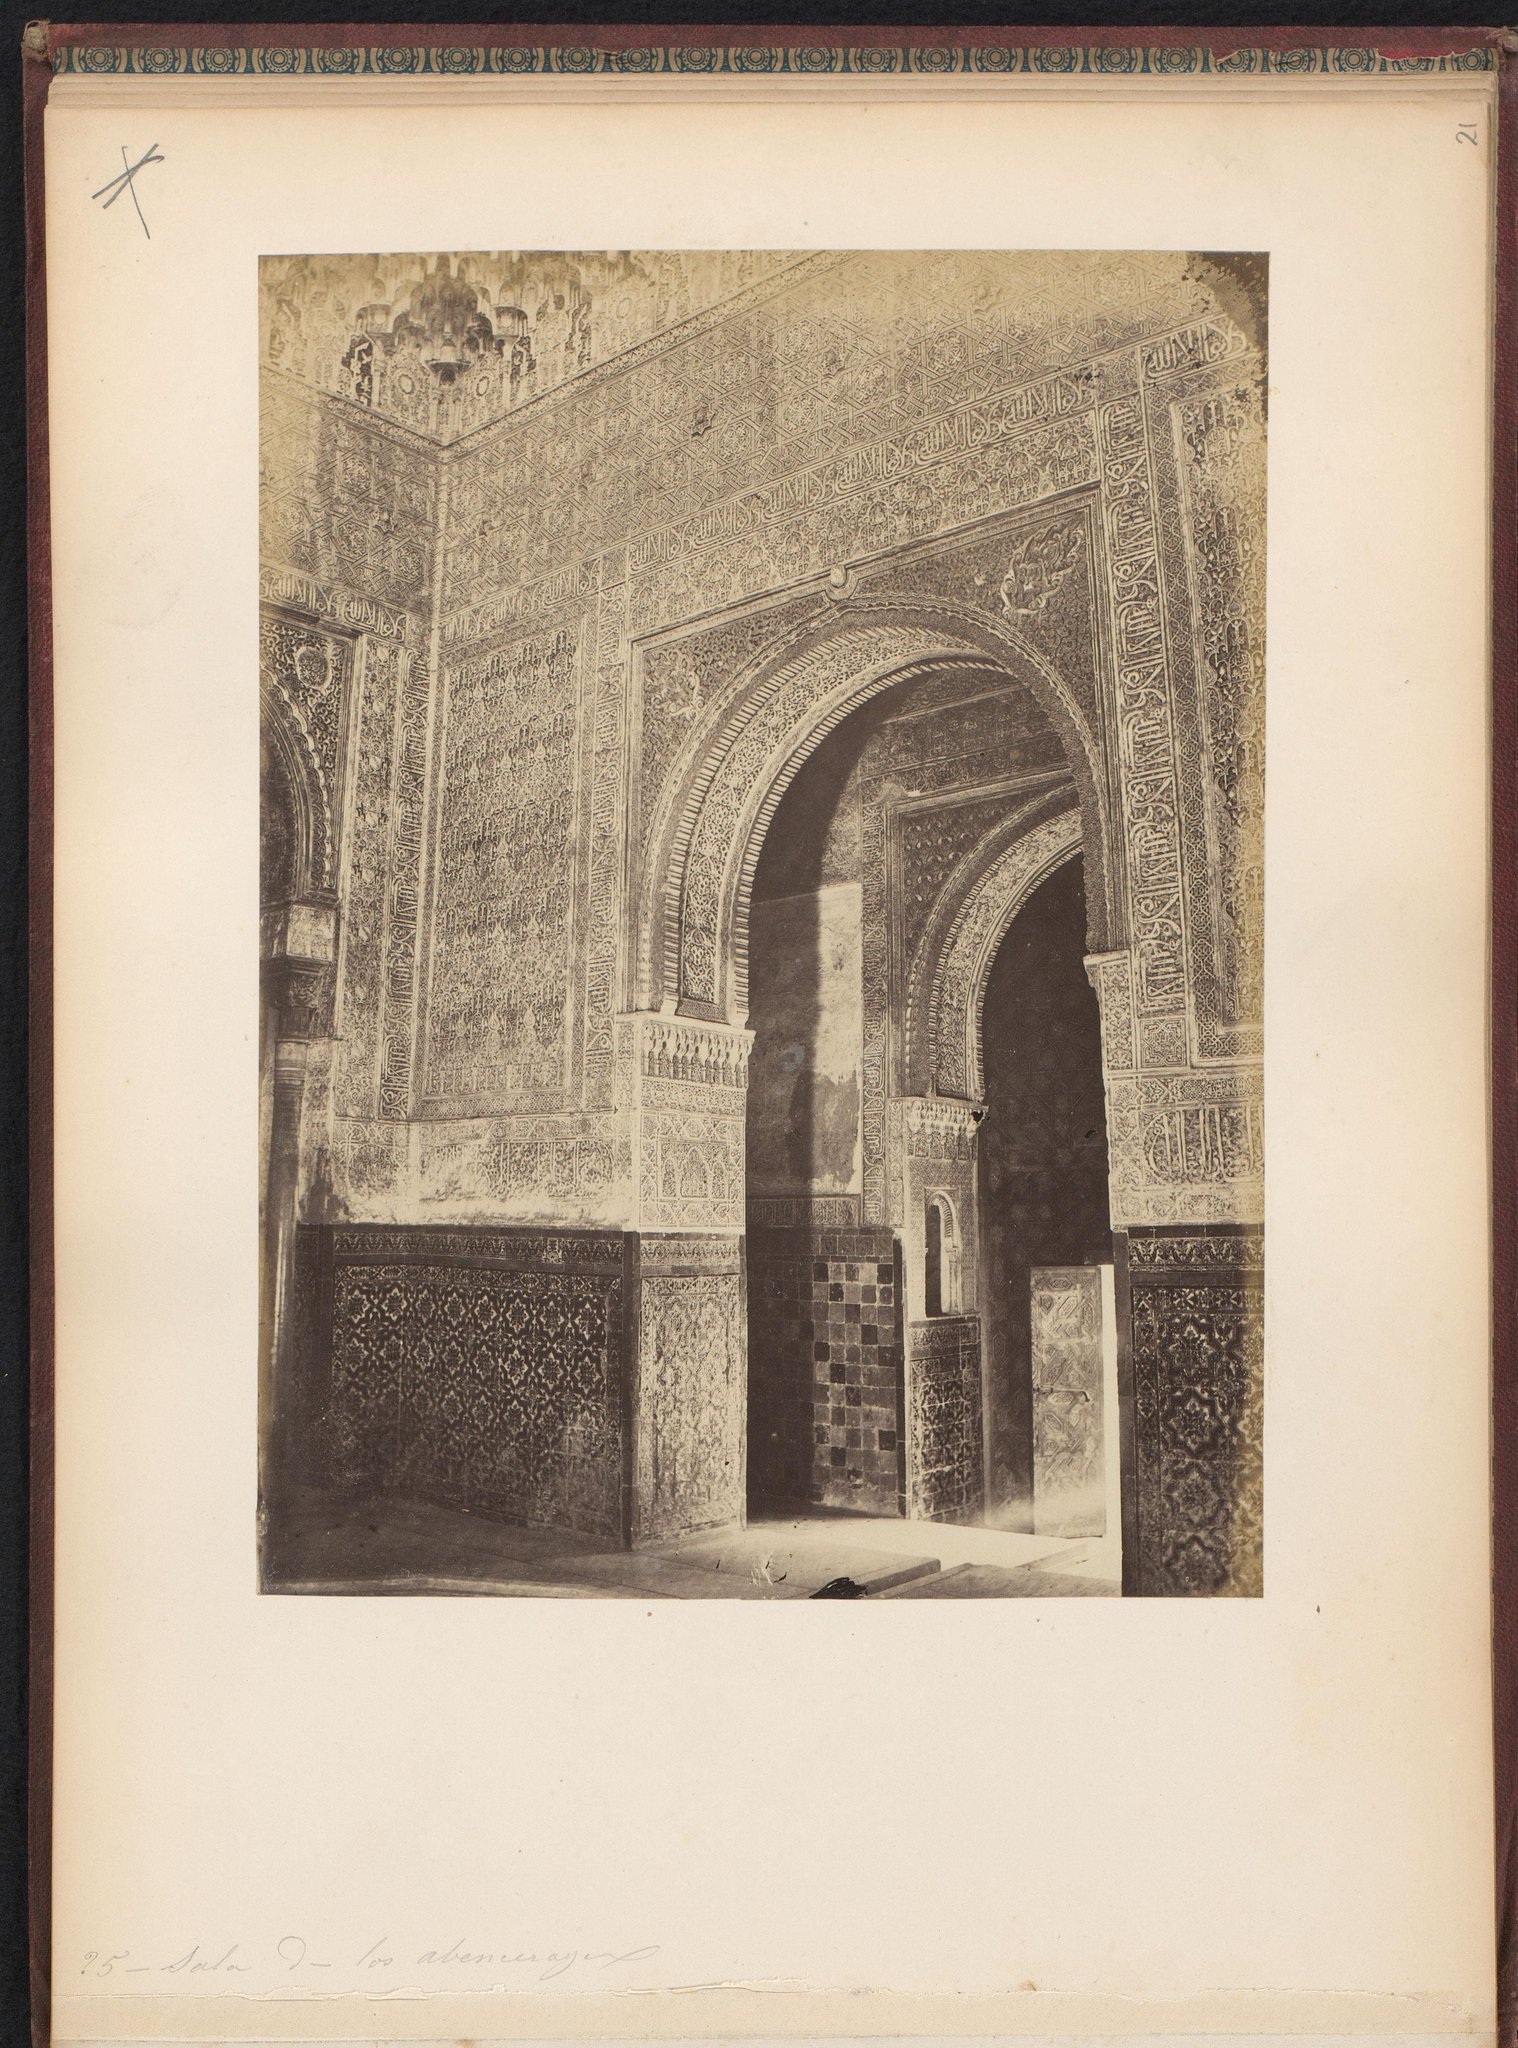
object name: photograph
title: Sala de los Abencerojes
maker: c maufsaise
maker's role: fotograaf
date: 1906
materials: paper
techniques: albumen print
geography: granada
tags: palace, interior ~ representation of a building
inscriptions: number: ‘25’, inscription